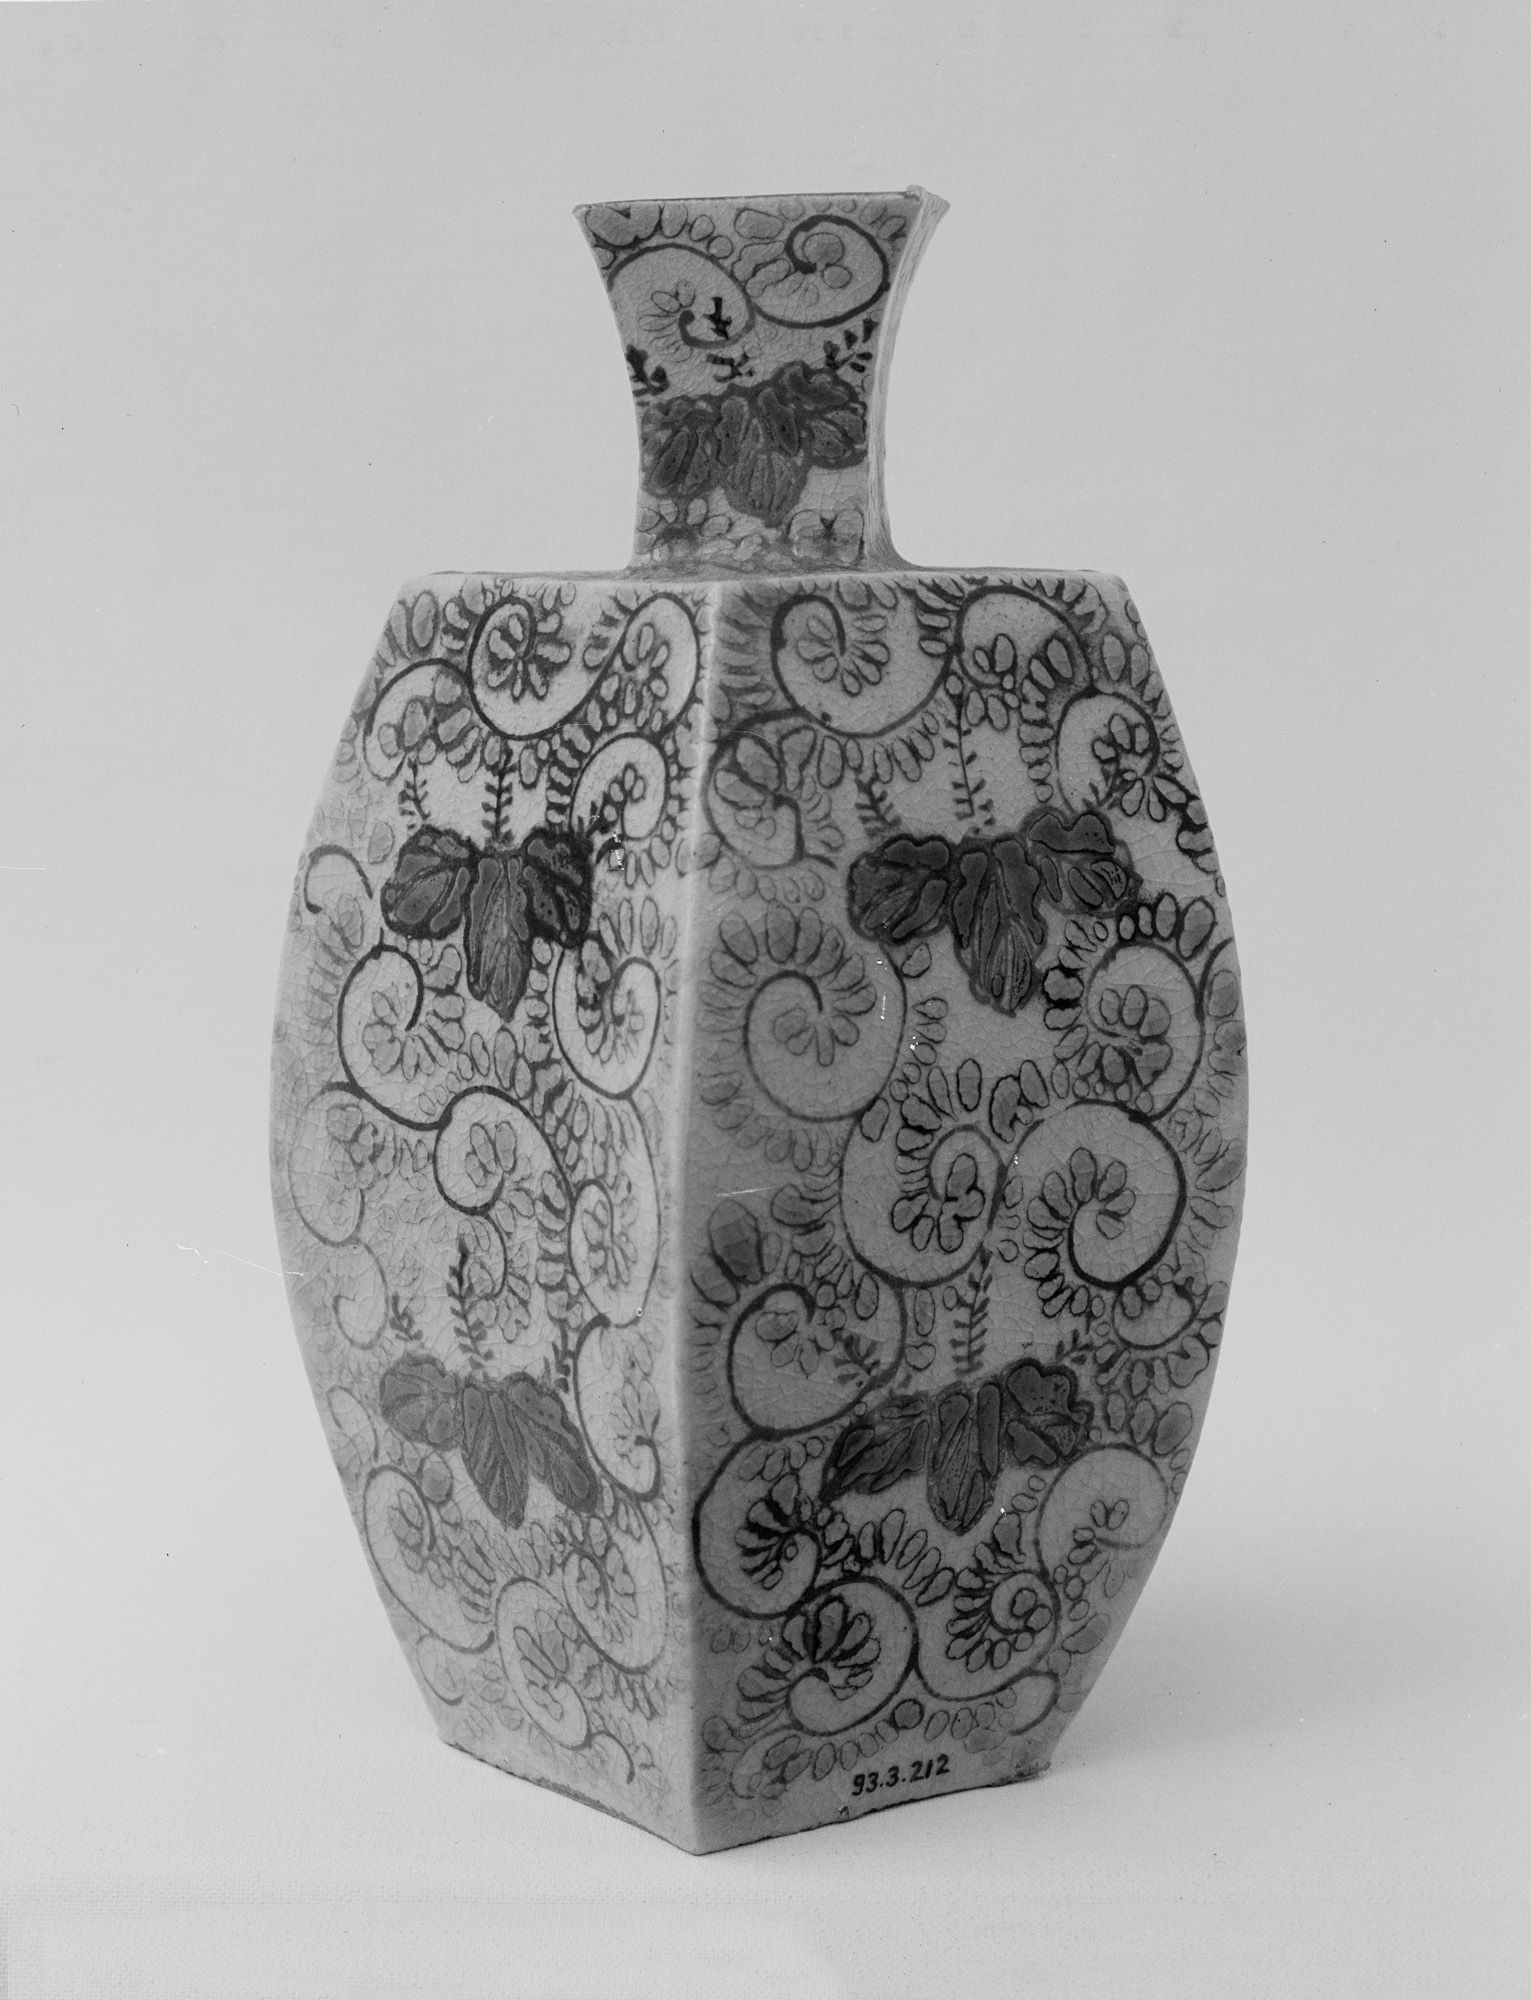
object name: vase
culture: japanese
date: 1730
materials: clay, enamel, glaze, gold